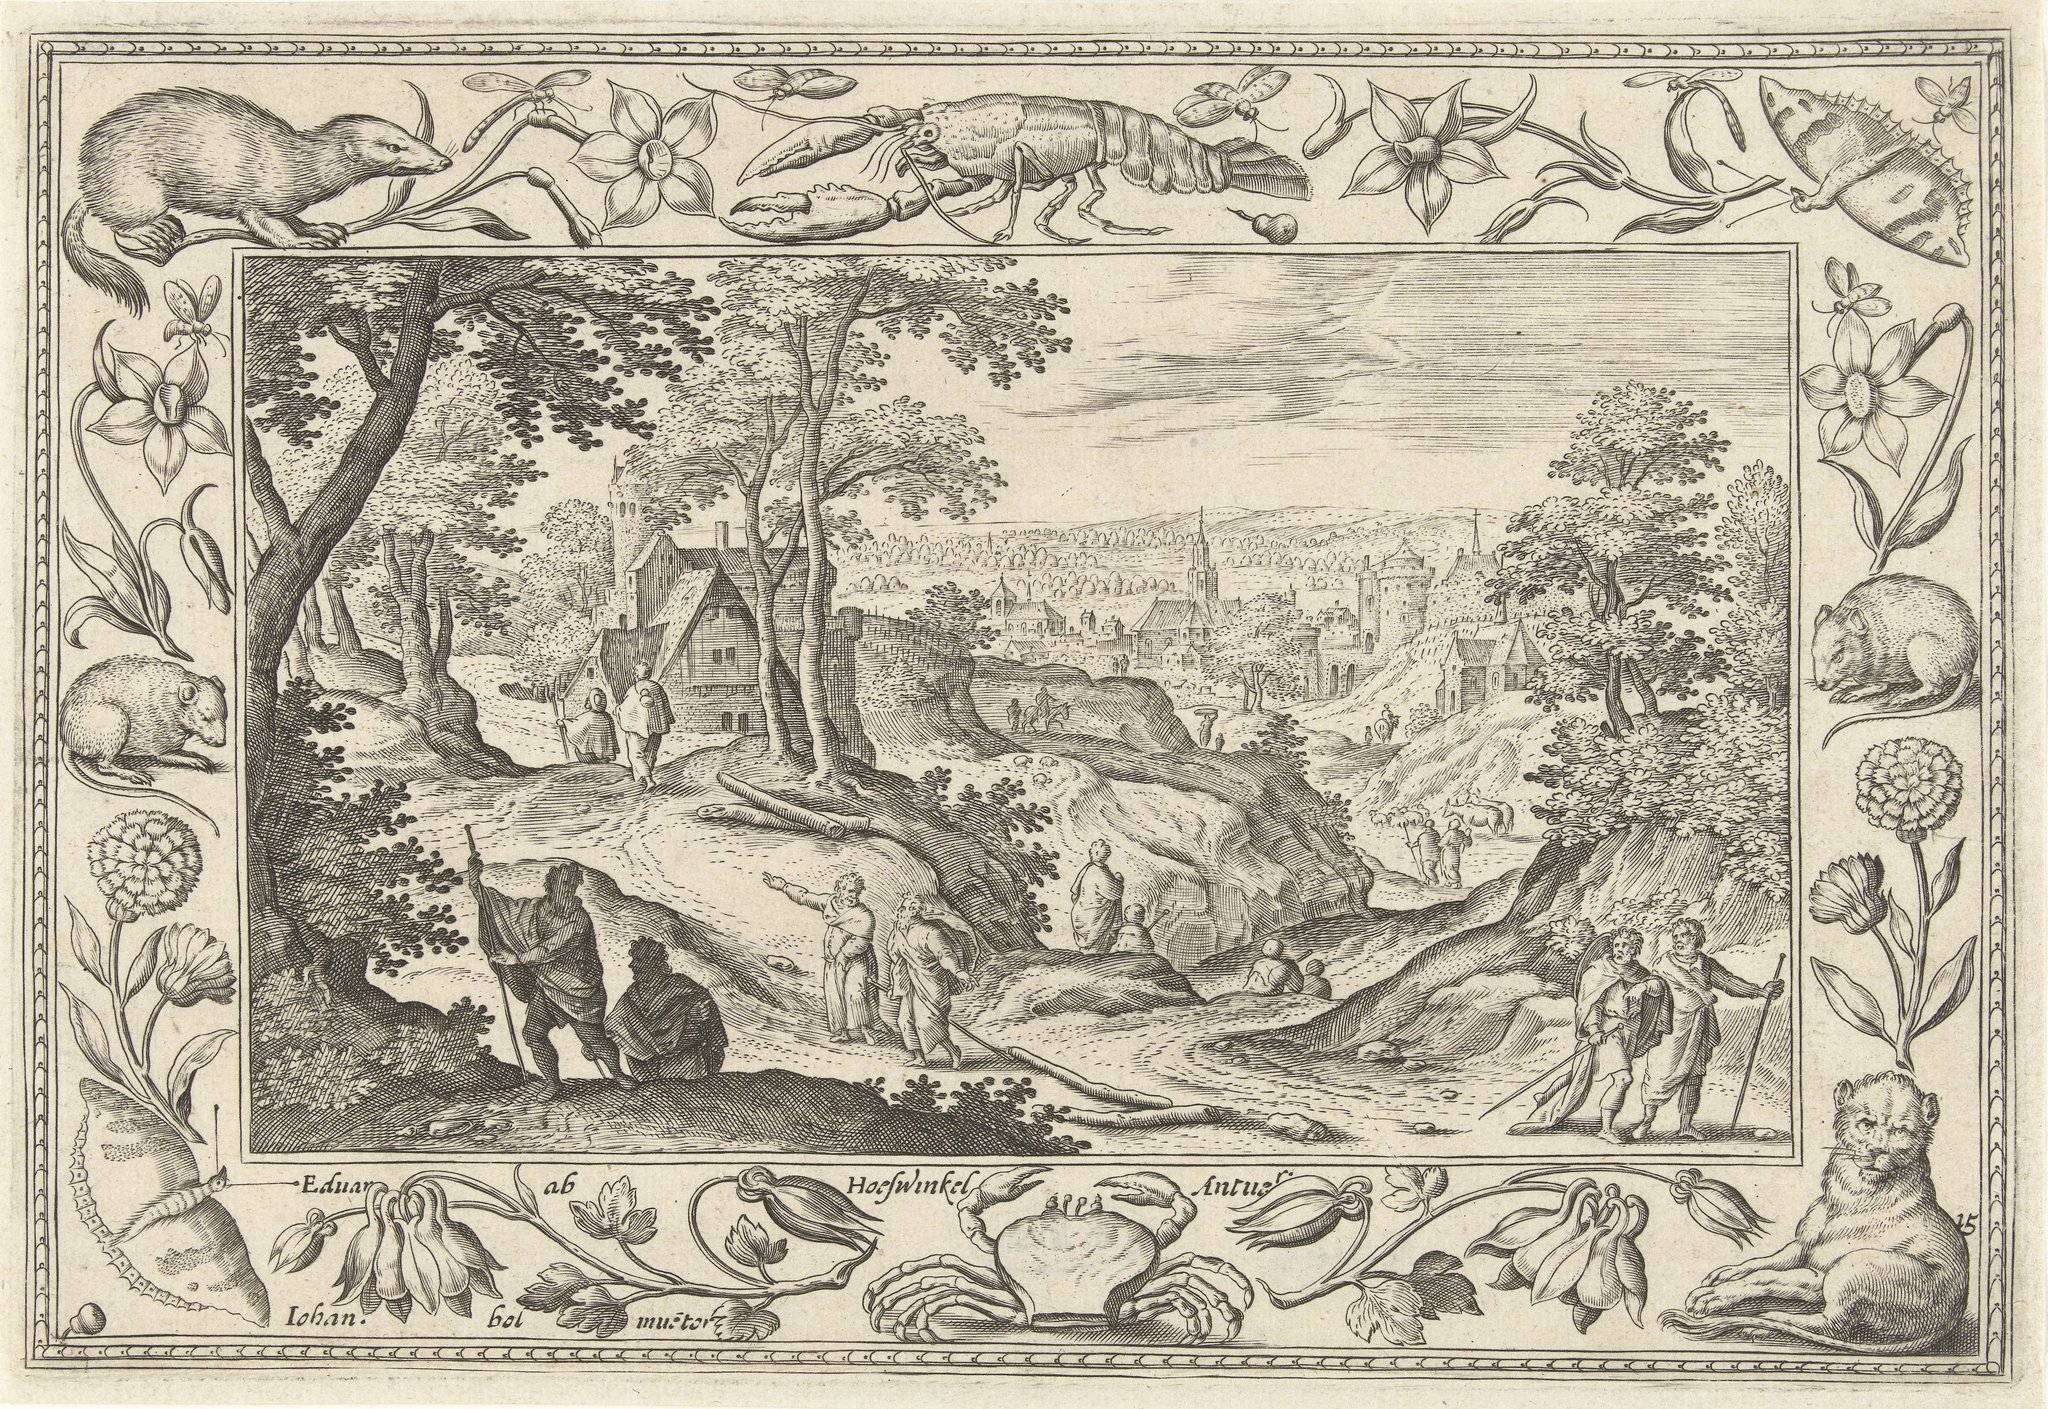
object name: print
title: Uitzending van de apostelen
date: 1582-1586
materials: paper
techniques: engraving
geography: antwerp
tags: christ sends apostles out in pairs (matthew 10:1-16; mark 6:7-11; luke 9:1-5), rodents: rat (+ ornamental variants of animals), insects: butterfly (+ ornamental variants of animals), crustaceans: lobster (+ ornamental variants of animals), public road, flowers ~ ornament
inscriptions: collector's mark: Lugt 2228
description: Landschap nmet een weg. Op verschillende plekken in het landschap apostelen, die in paren op reis zijn om de booschap van Christus te verkondigen. De prent heeft een ornamentele lijst met bloemen, vlinders en dieren. Hij maakt deel uit van een vierentwintigdelige serie van landschappen met Bijbelse, mythologische scènes en jachttaferelen.